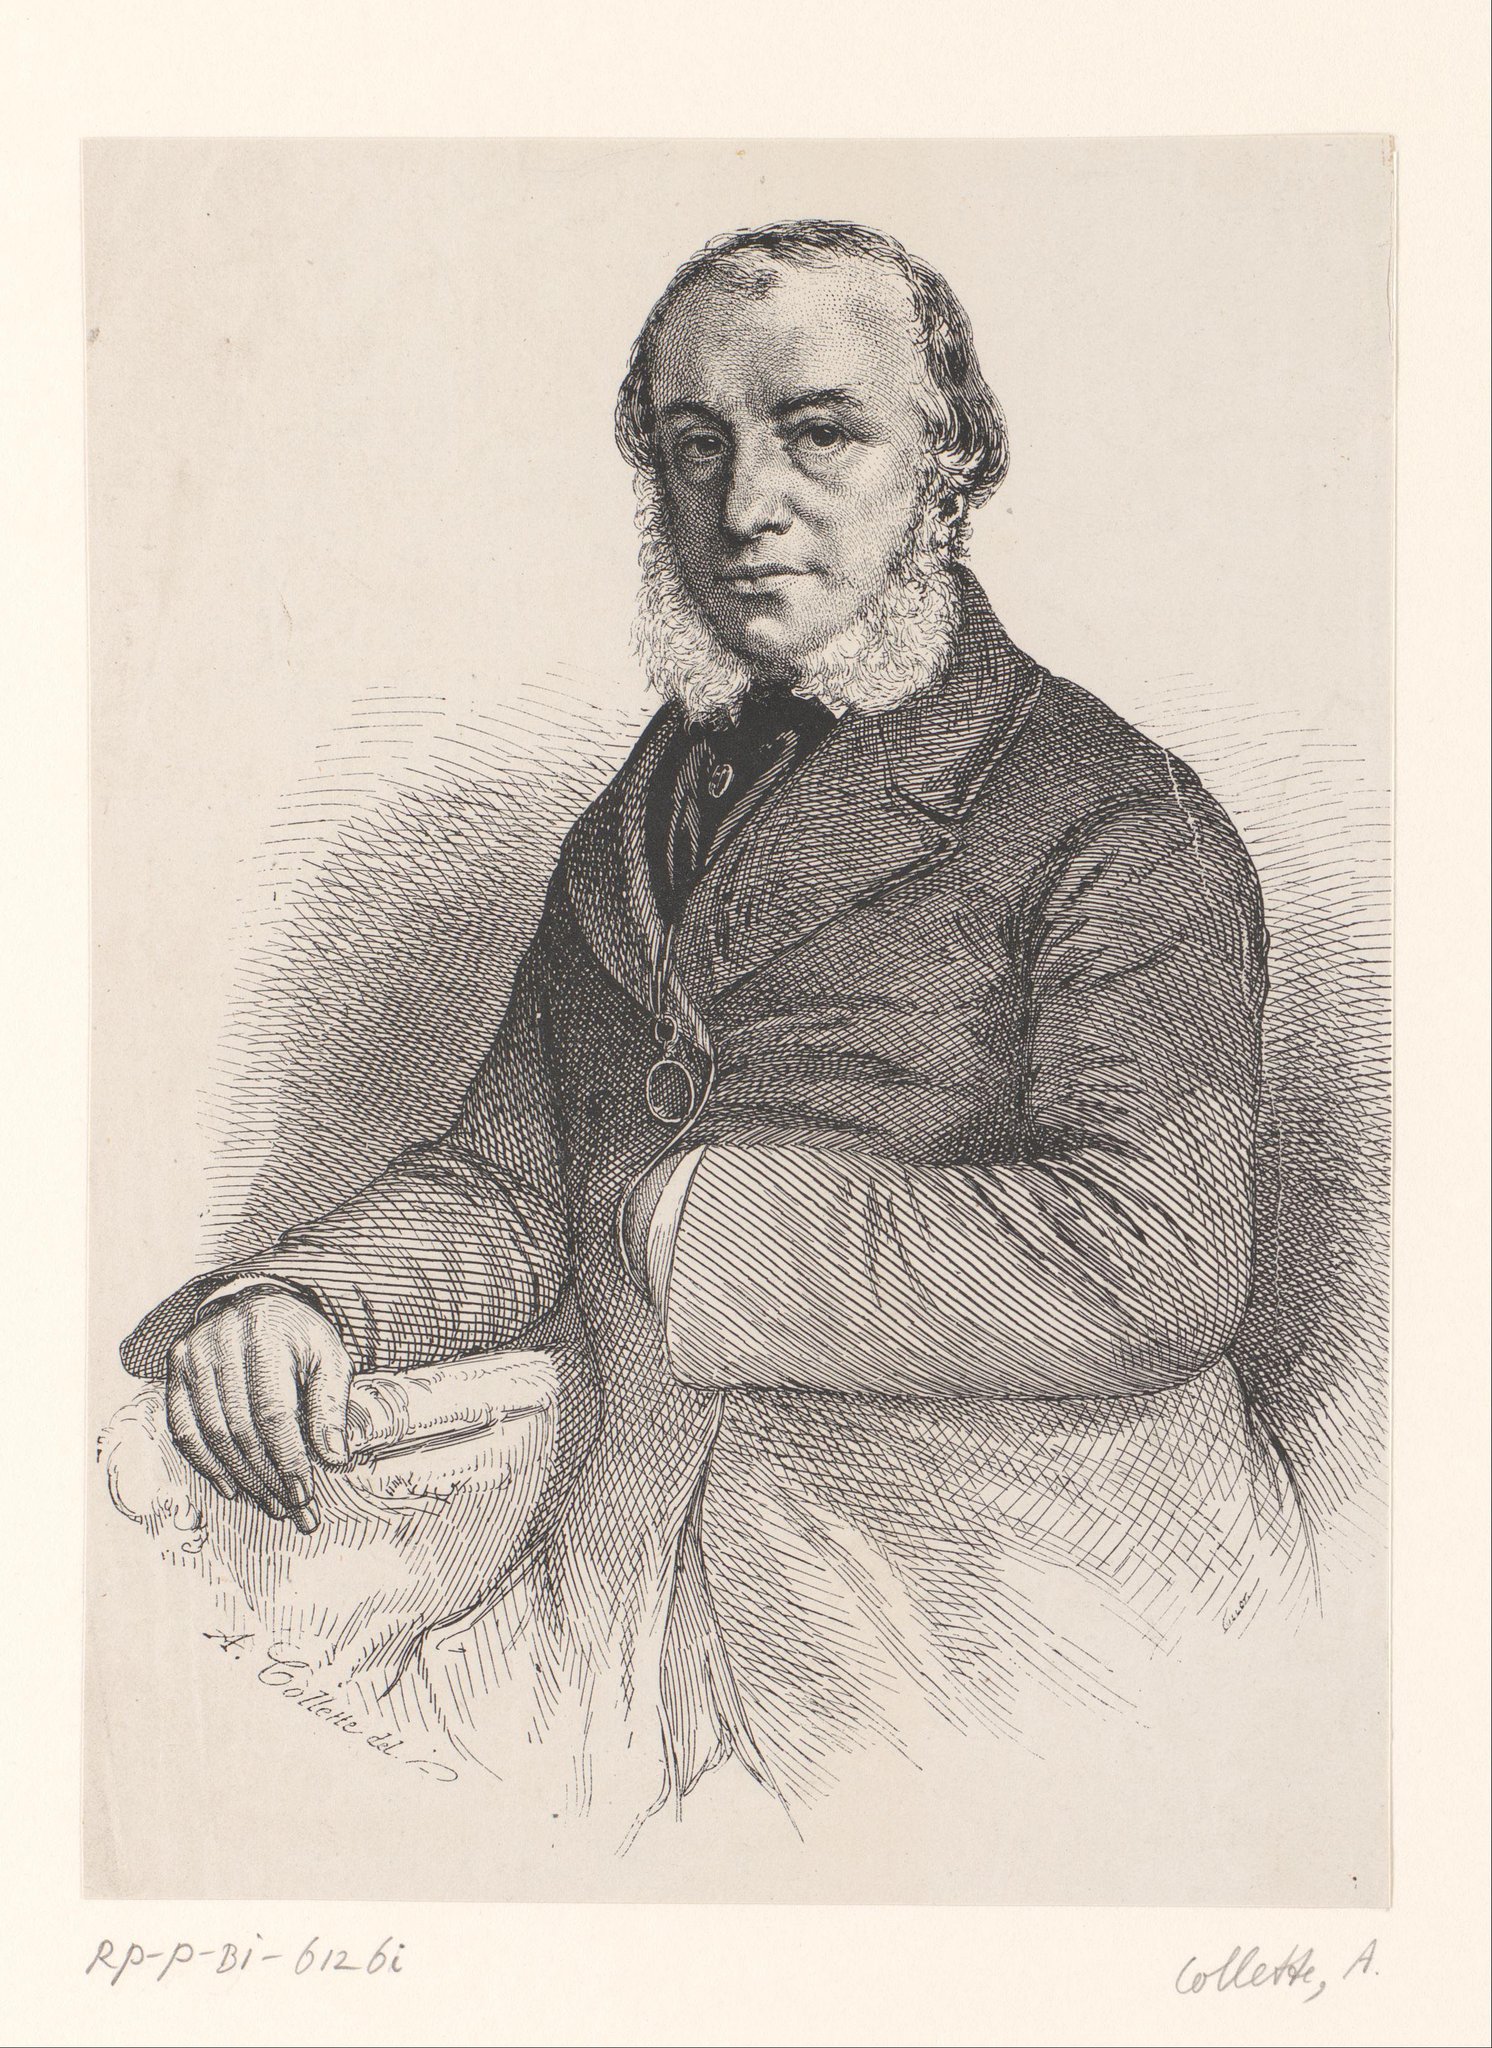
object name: print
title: Portret van een onbekende man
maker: alexandre collette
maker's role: print maker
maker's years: 1814-1876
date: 1836-1869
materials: paper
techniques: lithograph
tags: historical persons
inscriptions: collector's mark: Lugt 2228a